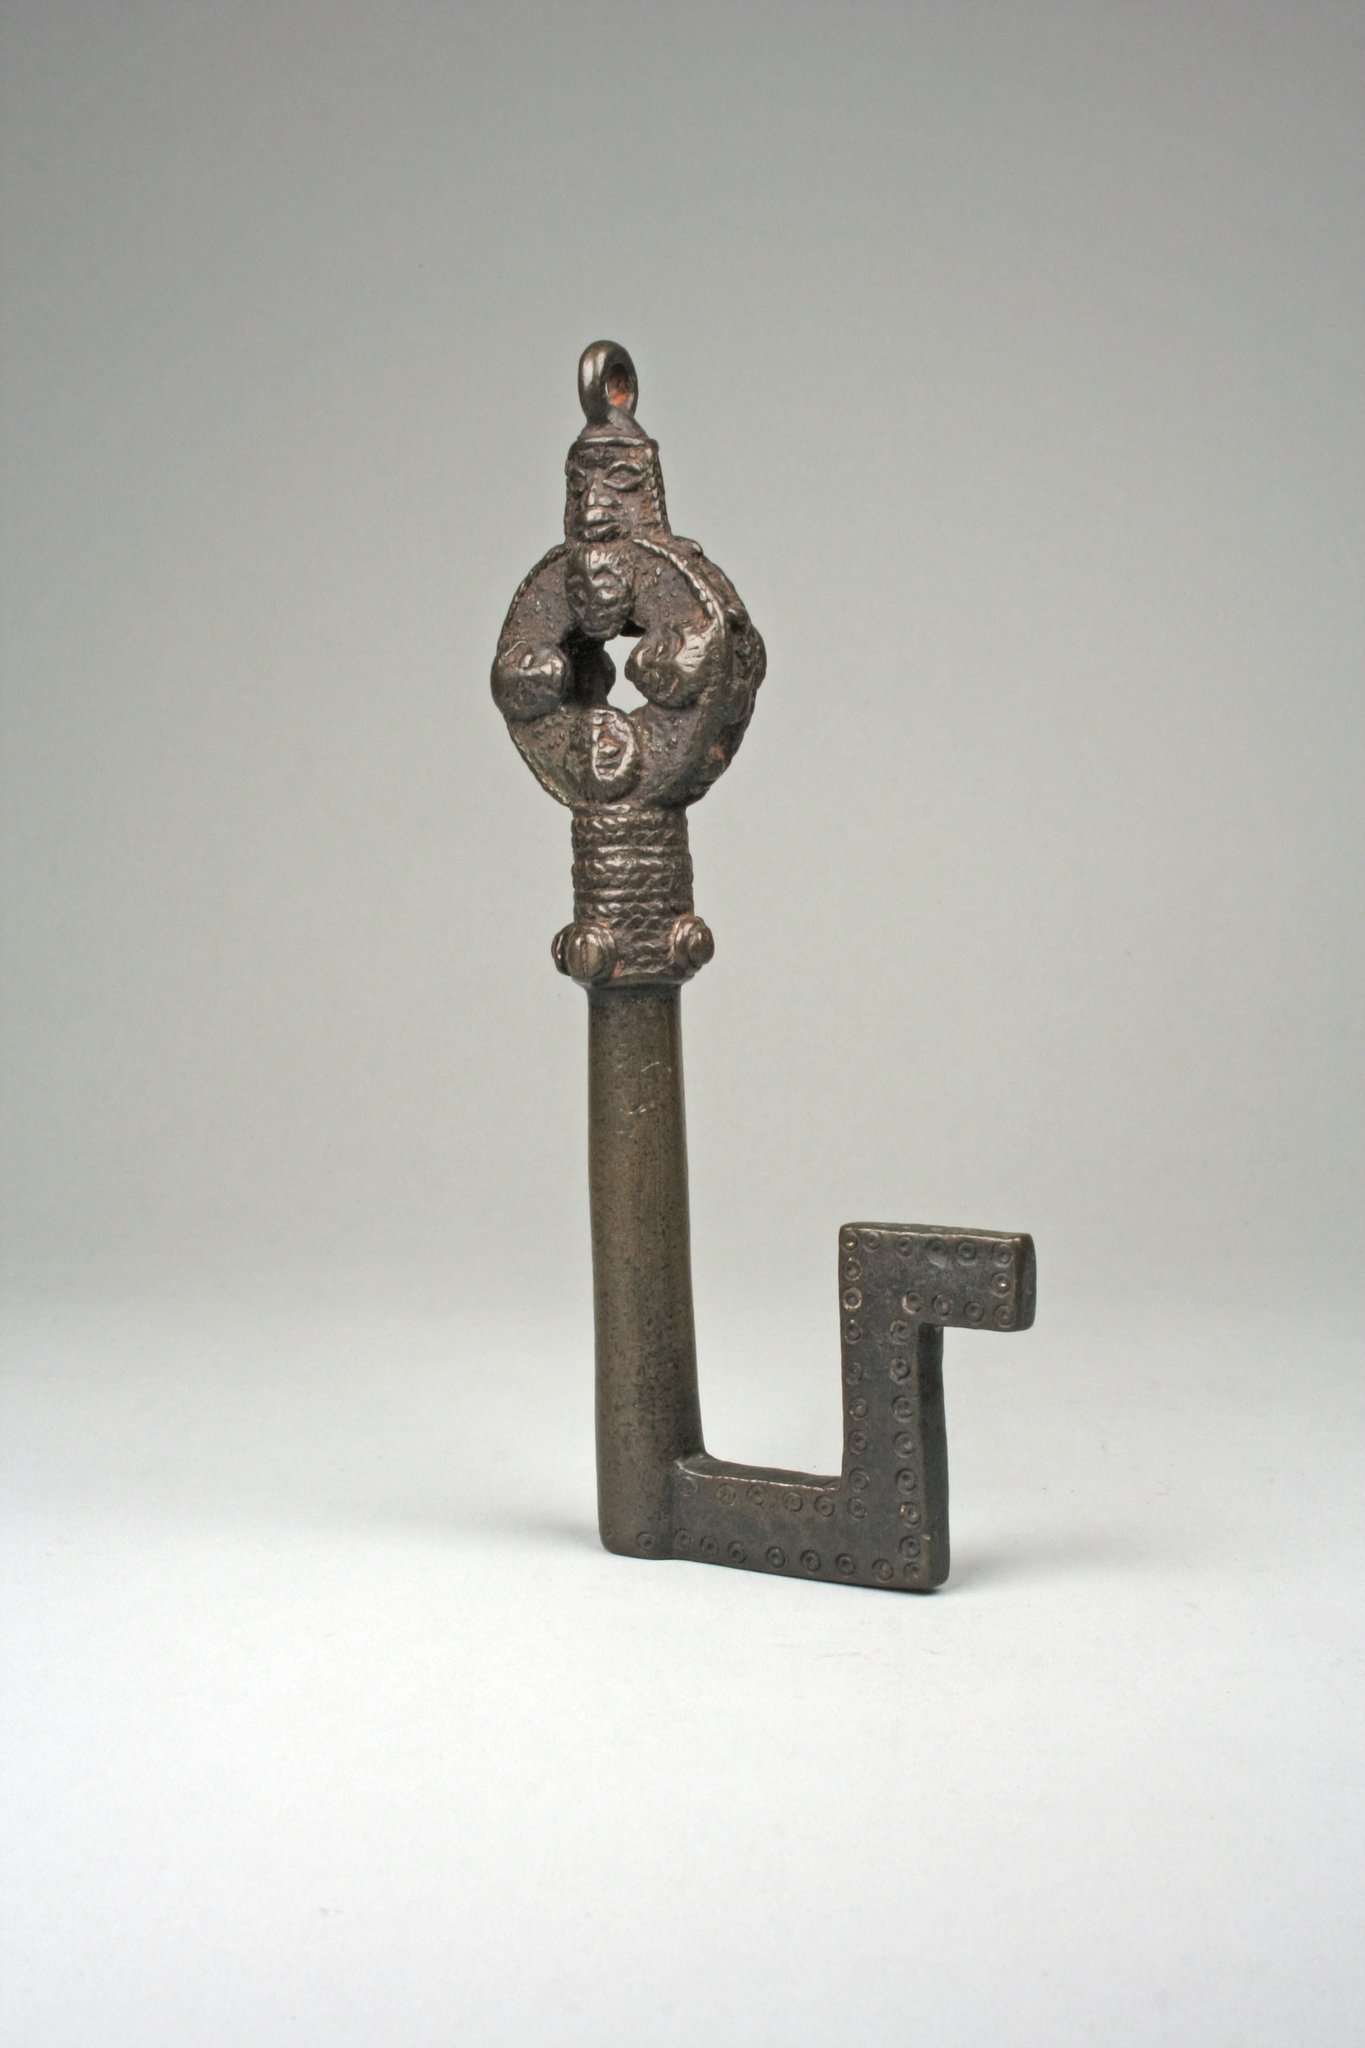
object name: key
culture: edo period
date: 1501-1900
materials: brass, iron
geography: nigeria